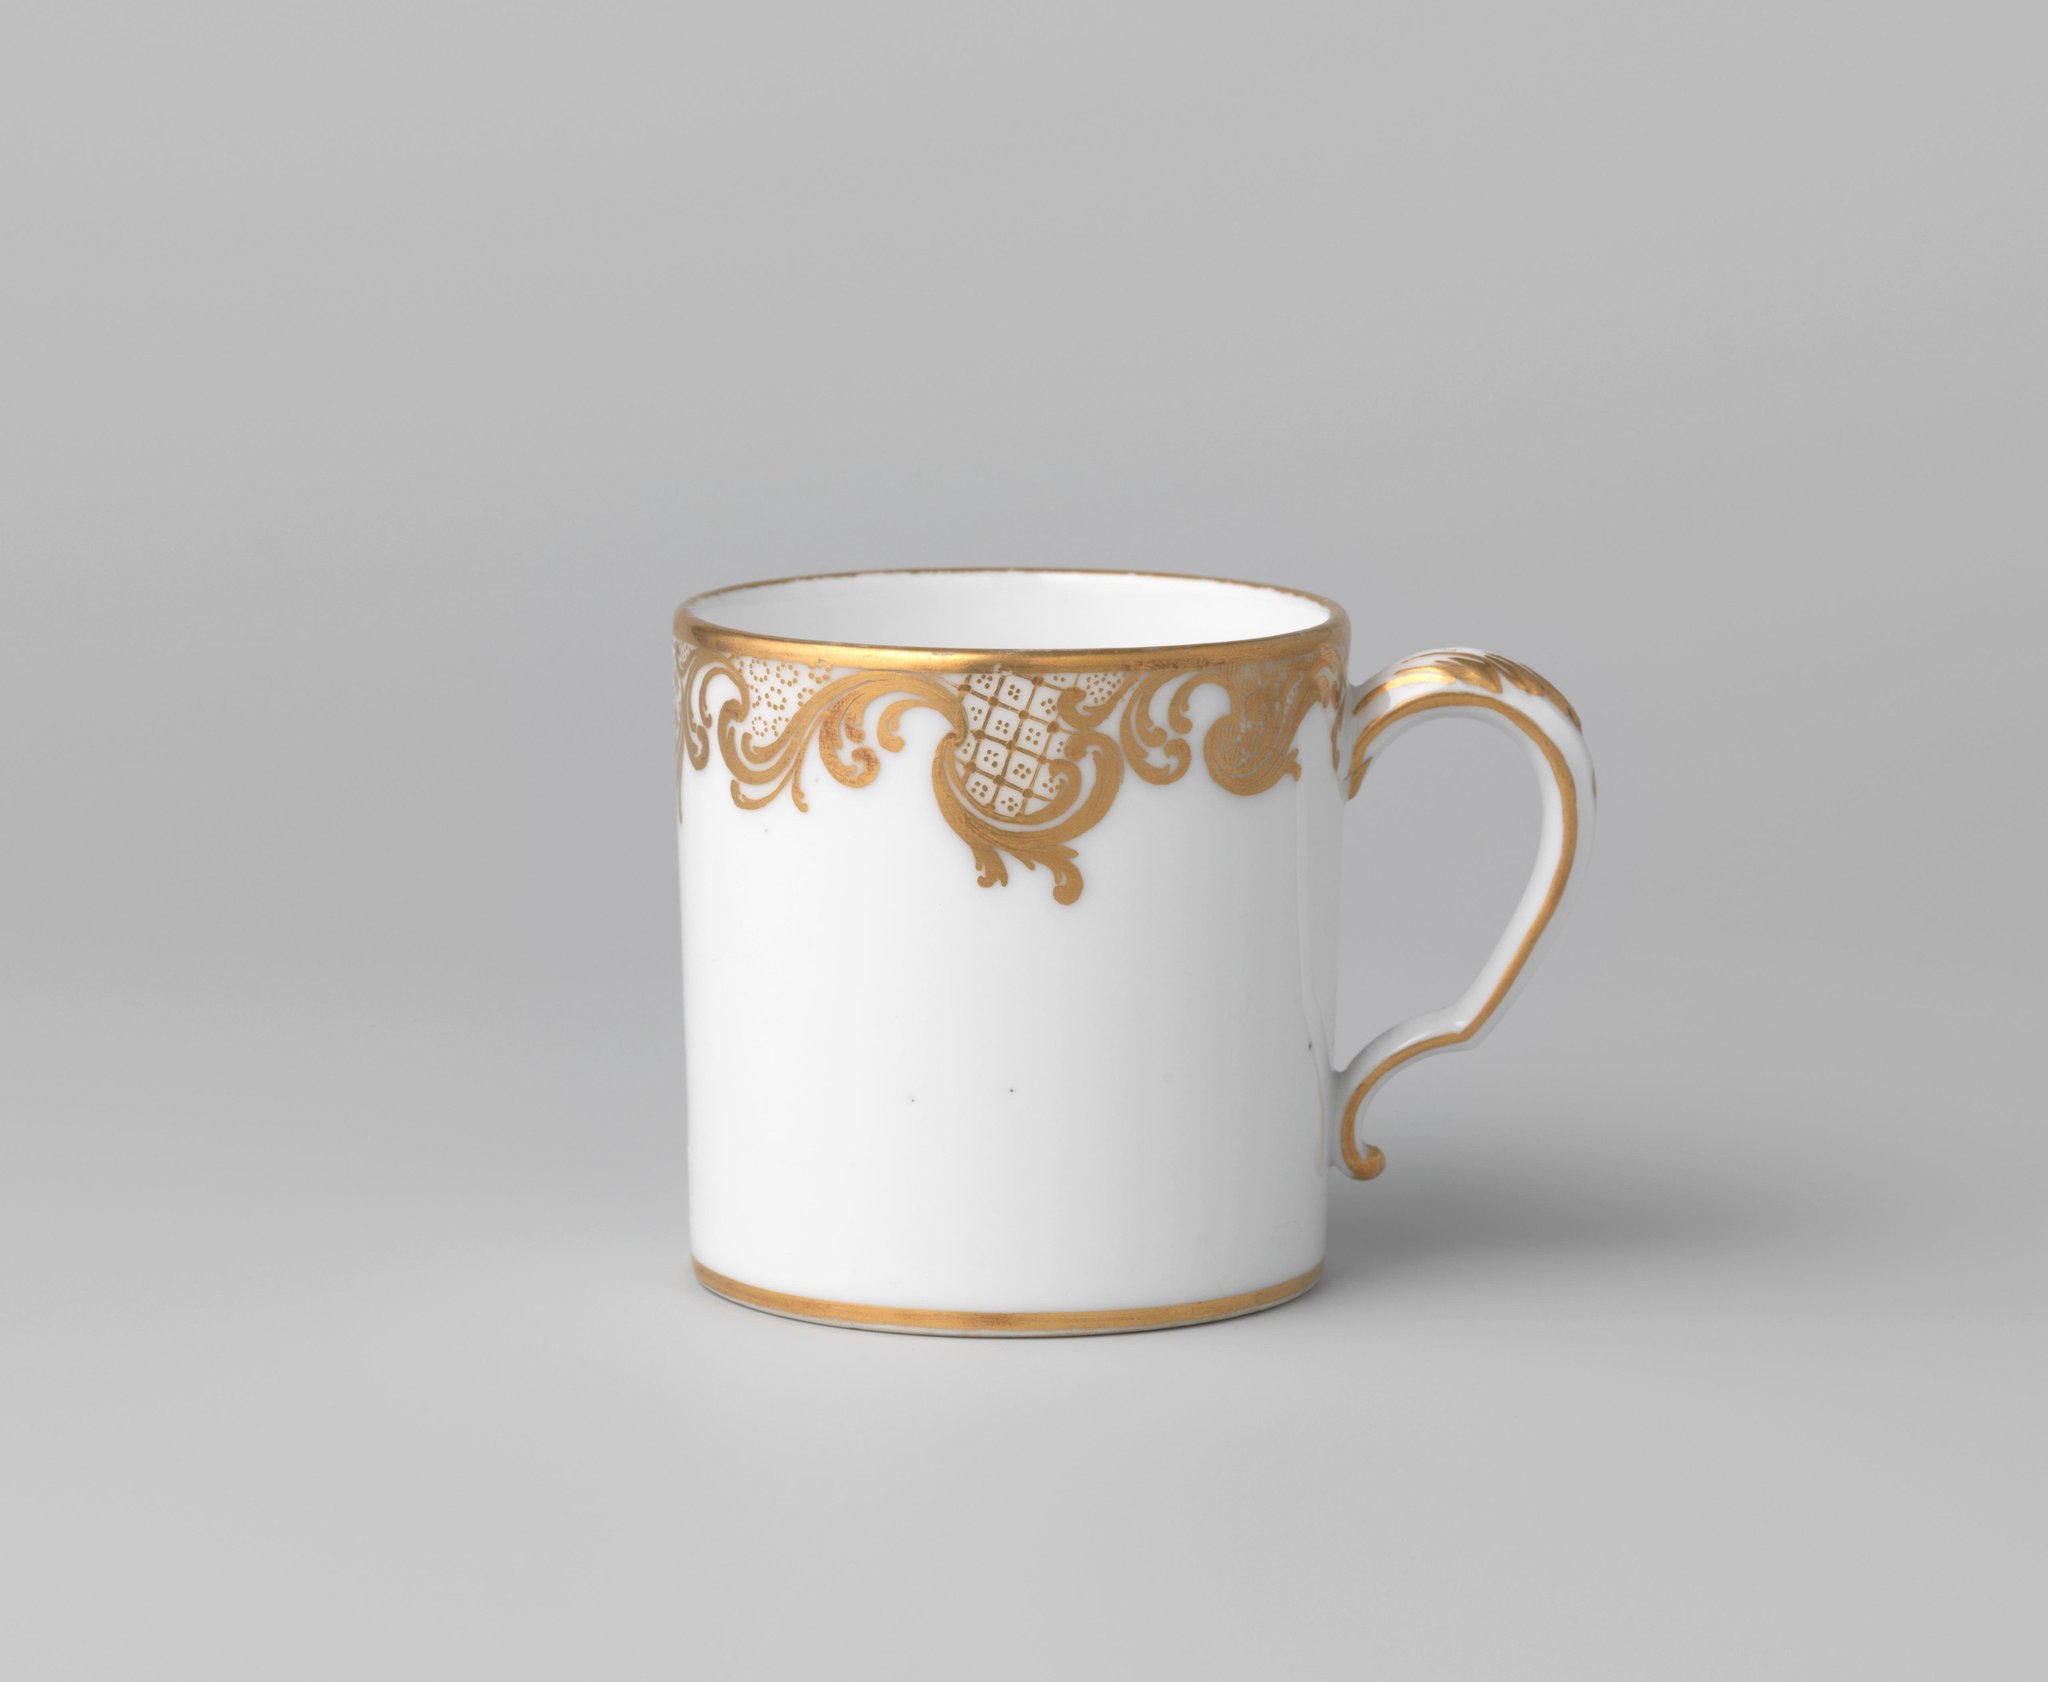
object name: cup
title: Cup with a foliate scrolls and diaper pattern border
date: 1754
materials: glaze, gold, paint, porcelain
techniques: firing, forming, gilding, turning, vitrification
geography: vincennes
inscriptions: mark: ‘gekroonde dubbele L/ B/ Z/ M’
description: Kop van porselein met een cilindrische wand en C-vormig oor, beschilderd op het glazuur in goud. Op de buitenrand een band met bladranken en servetwerk. Gouden lijn op de voet en de rand. Het oor met stippen, bladmotieven en een gemodelleerde bladrank. Gemerkt op de onderzijde met de gekroonde dubbele L, waaronder een B, en een Z en een M.